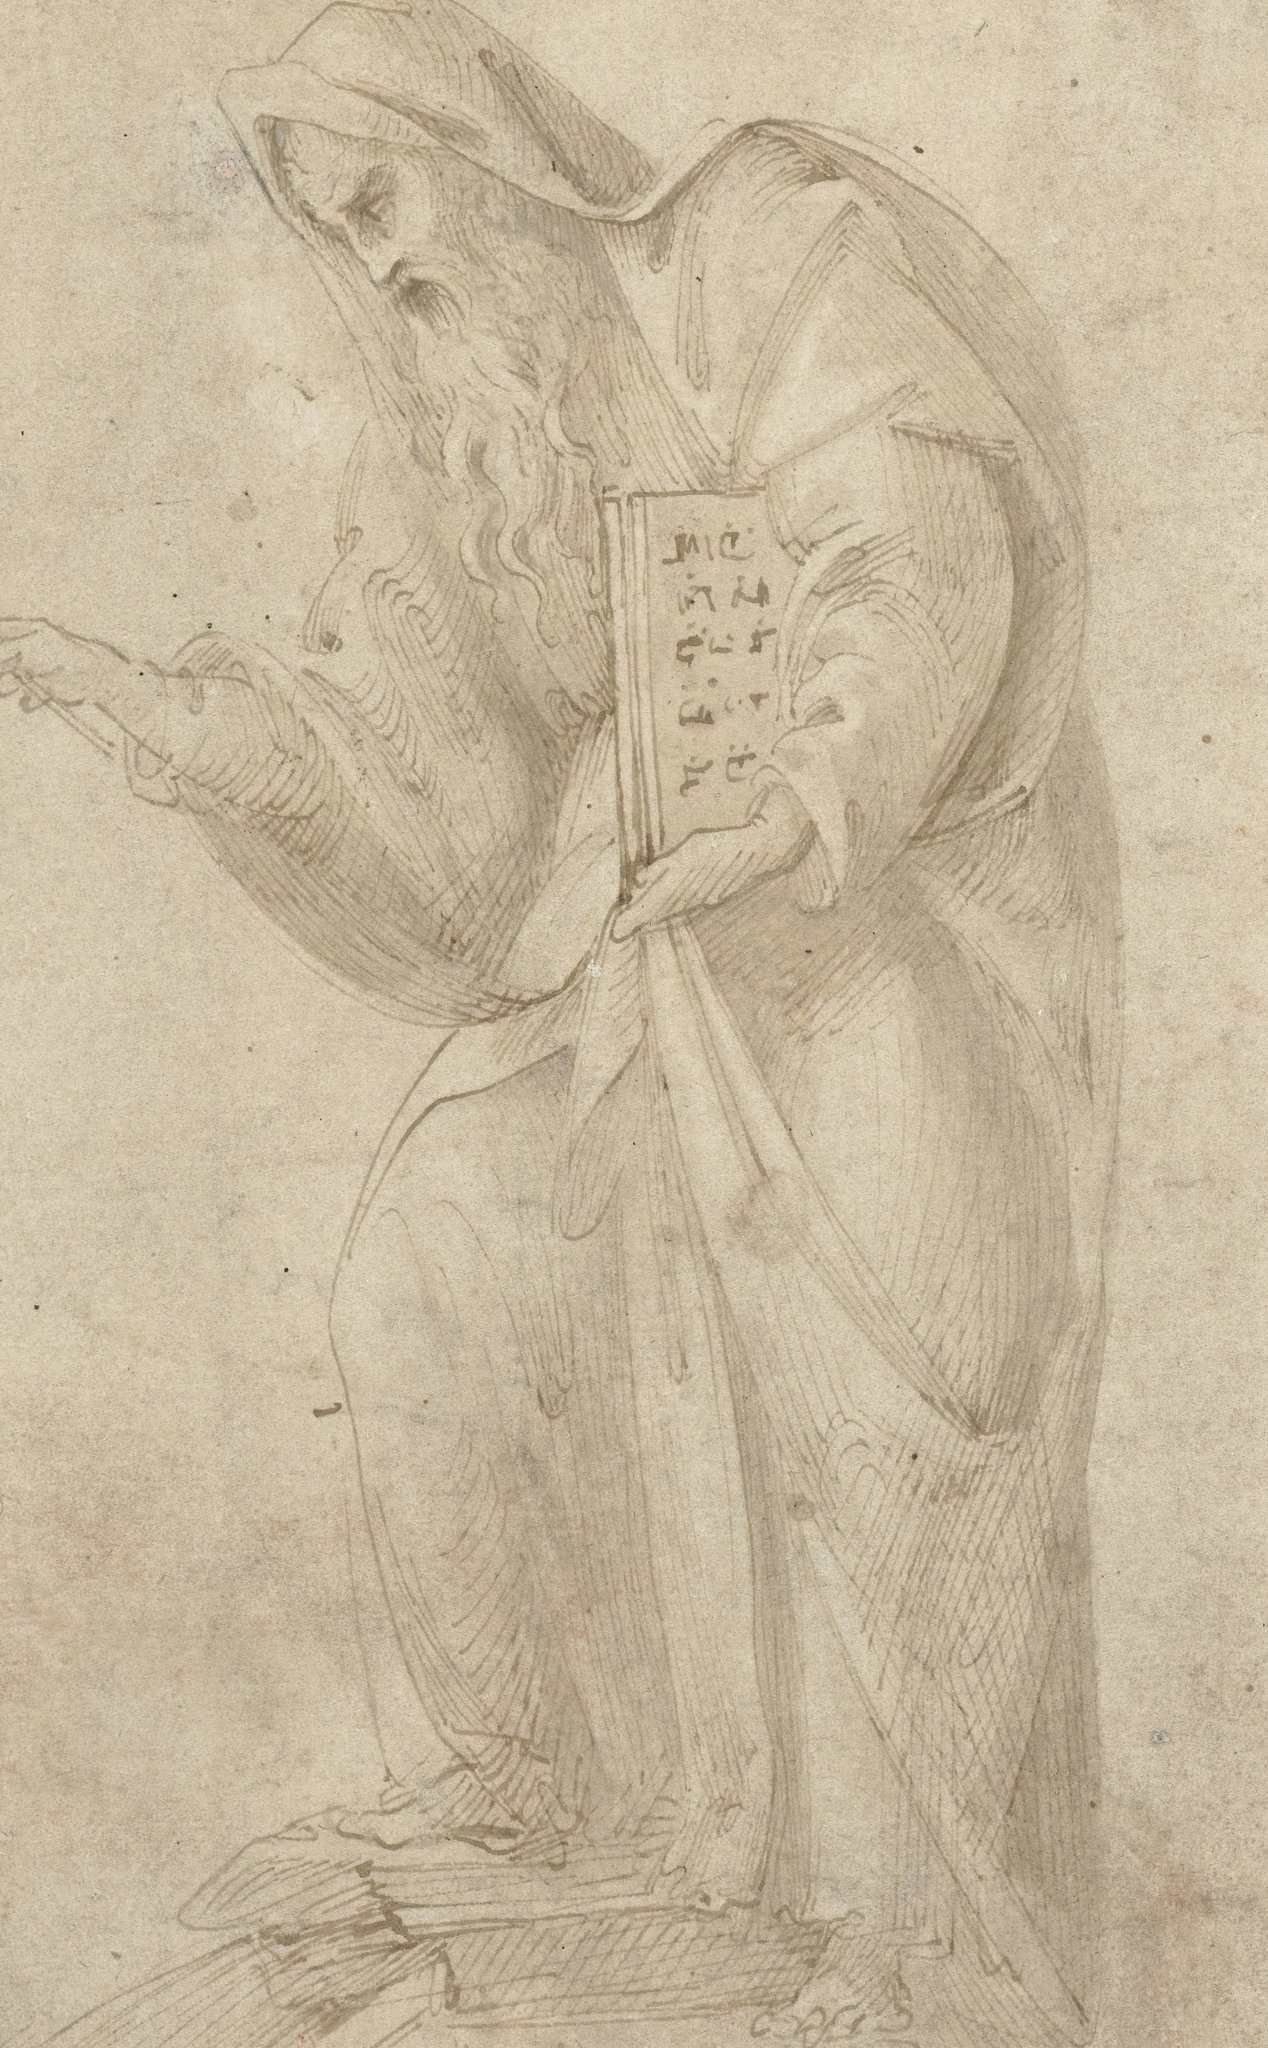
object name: drawing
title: Mozes met de tafelen der wet en een staf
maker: Anonymous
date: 1480-1540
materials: ink, paper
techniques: brush, pen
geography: florence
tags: moses on mount sinai with the tables of the law (exodus 24:9-18, 31:18)